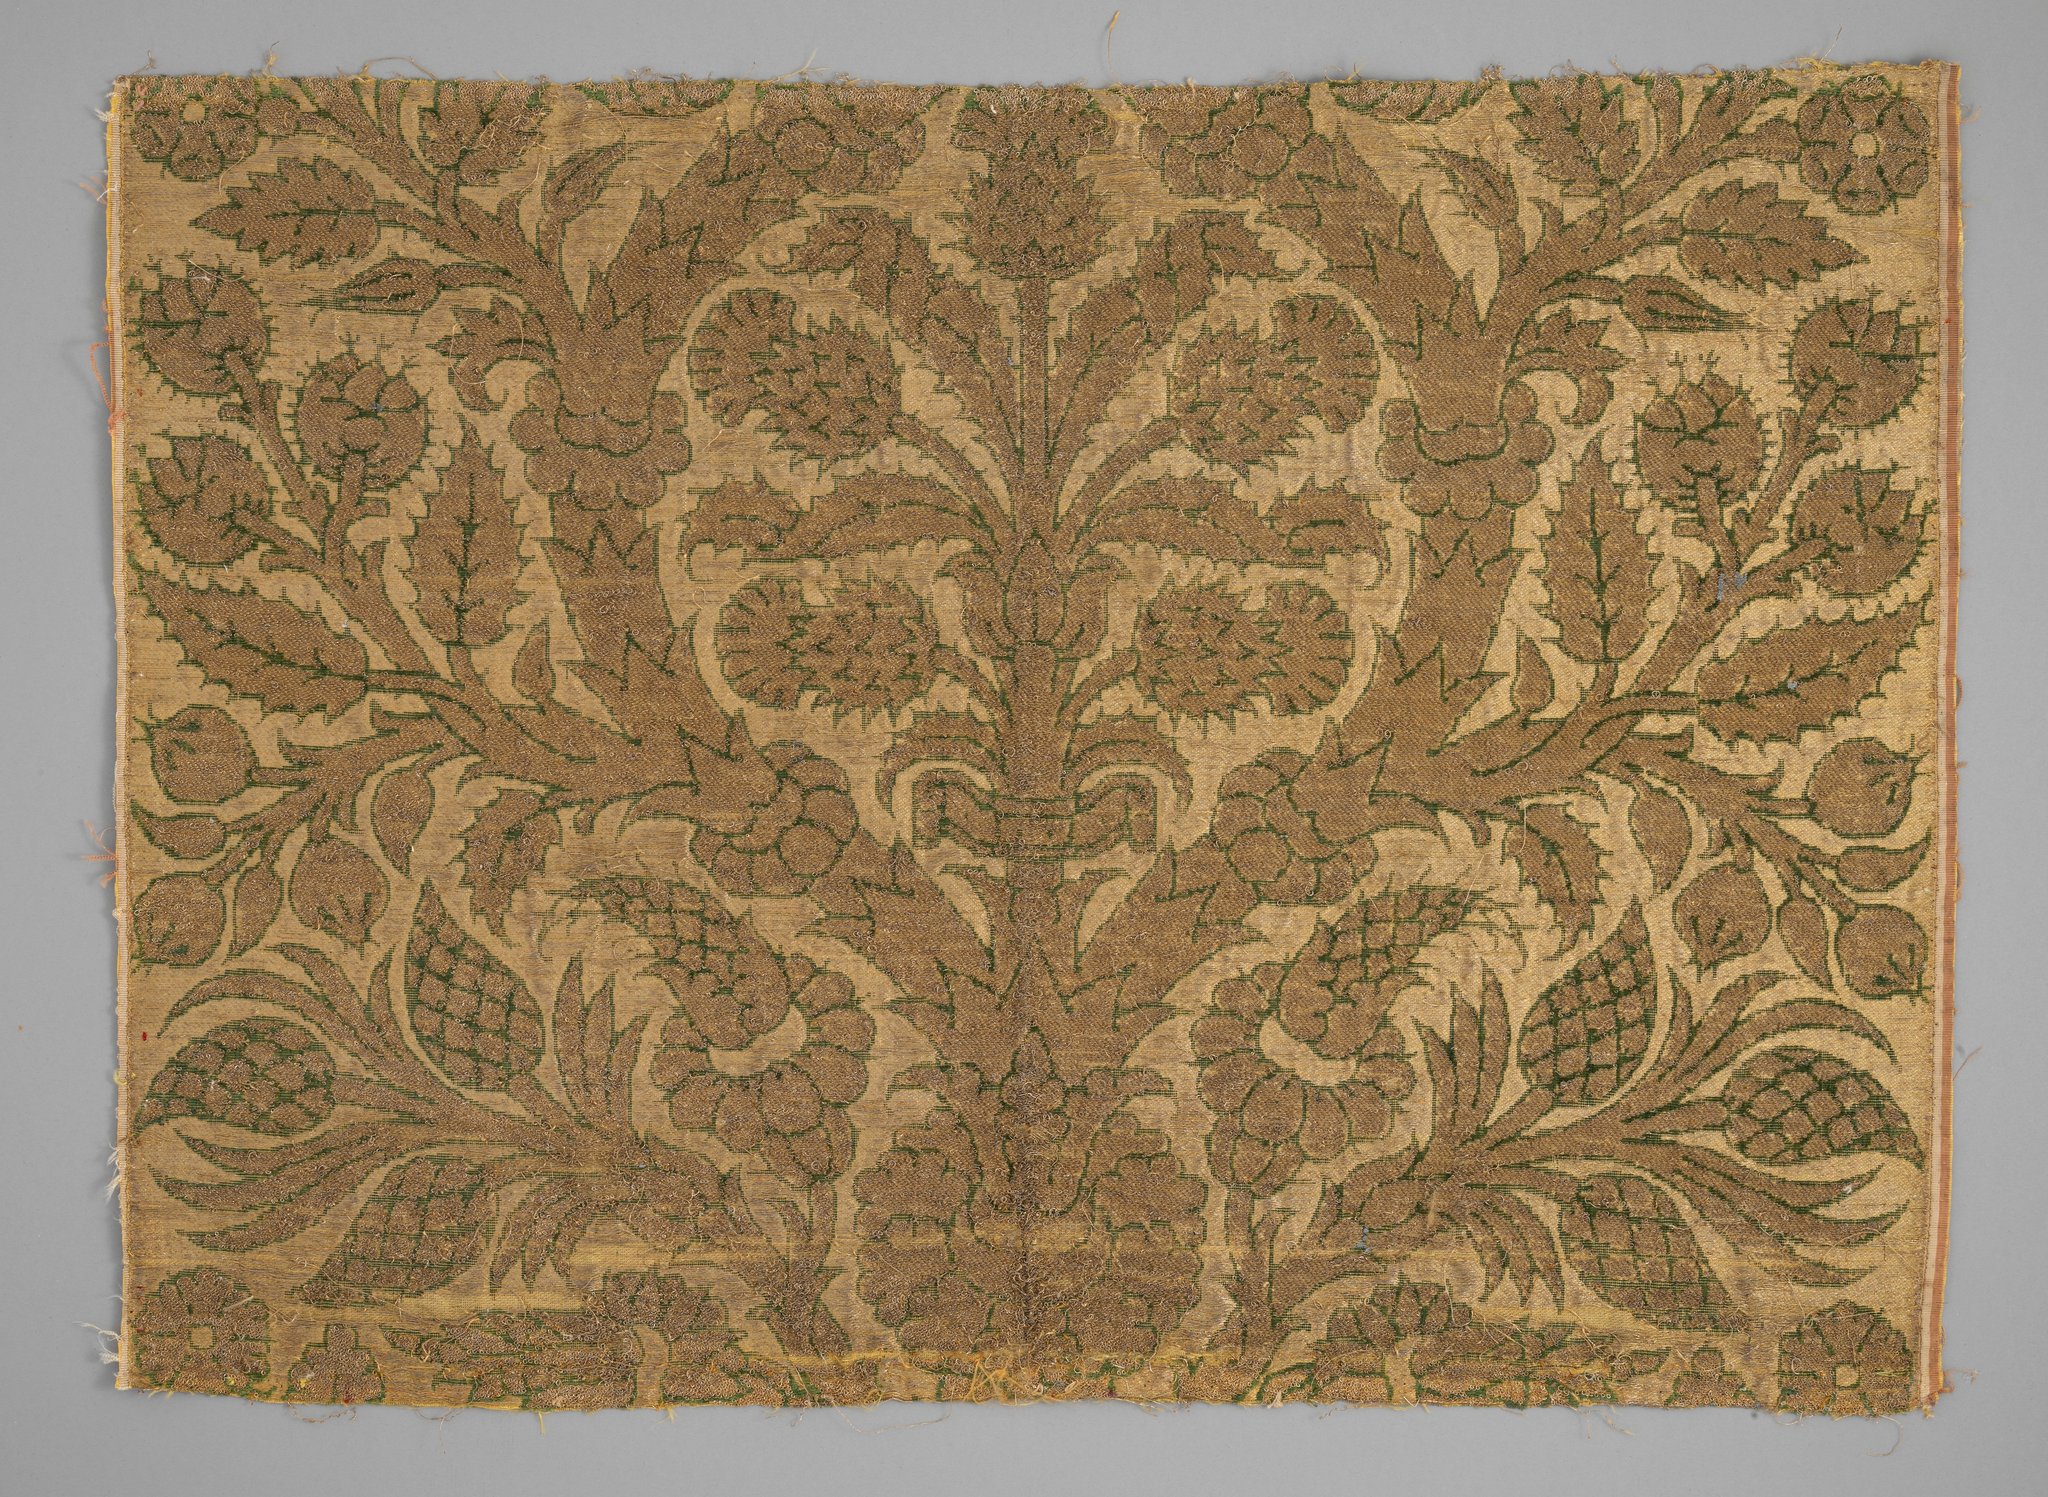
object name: piece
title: Fragment with Sempervivum tectorum motif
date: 1475-1525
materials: metal thread, silk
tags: flowers,leaves